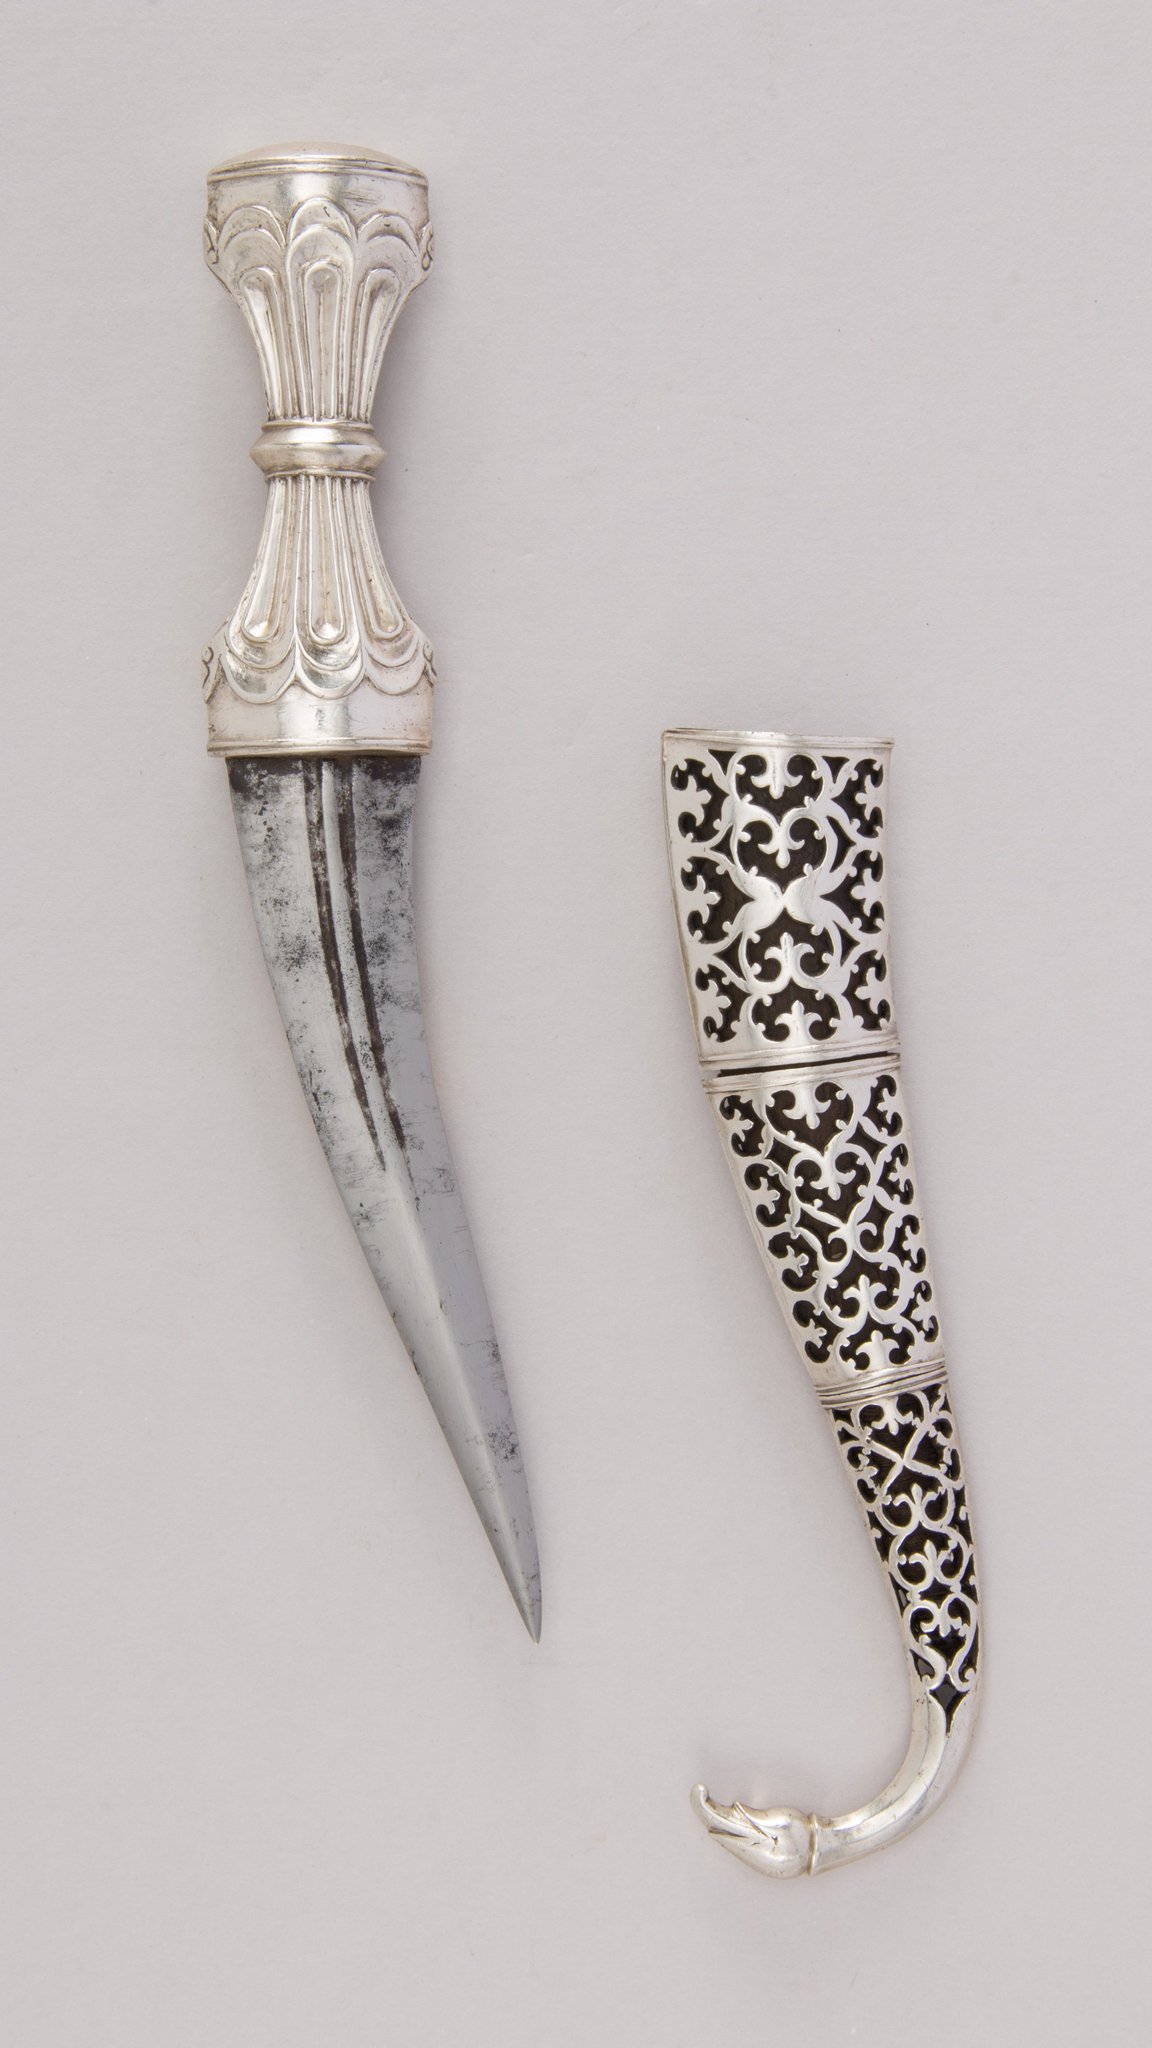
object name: dagger with sheath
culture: south indian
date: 1701-1900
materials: silver, steel, wood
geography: south india